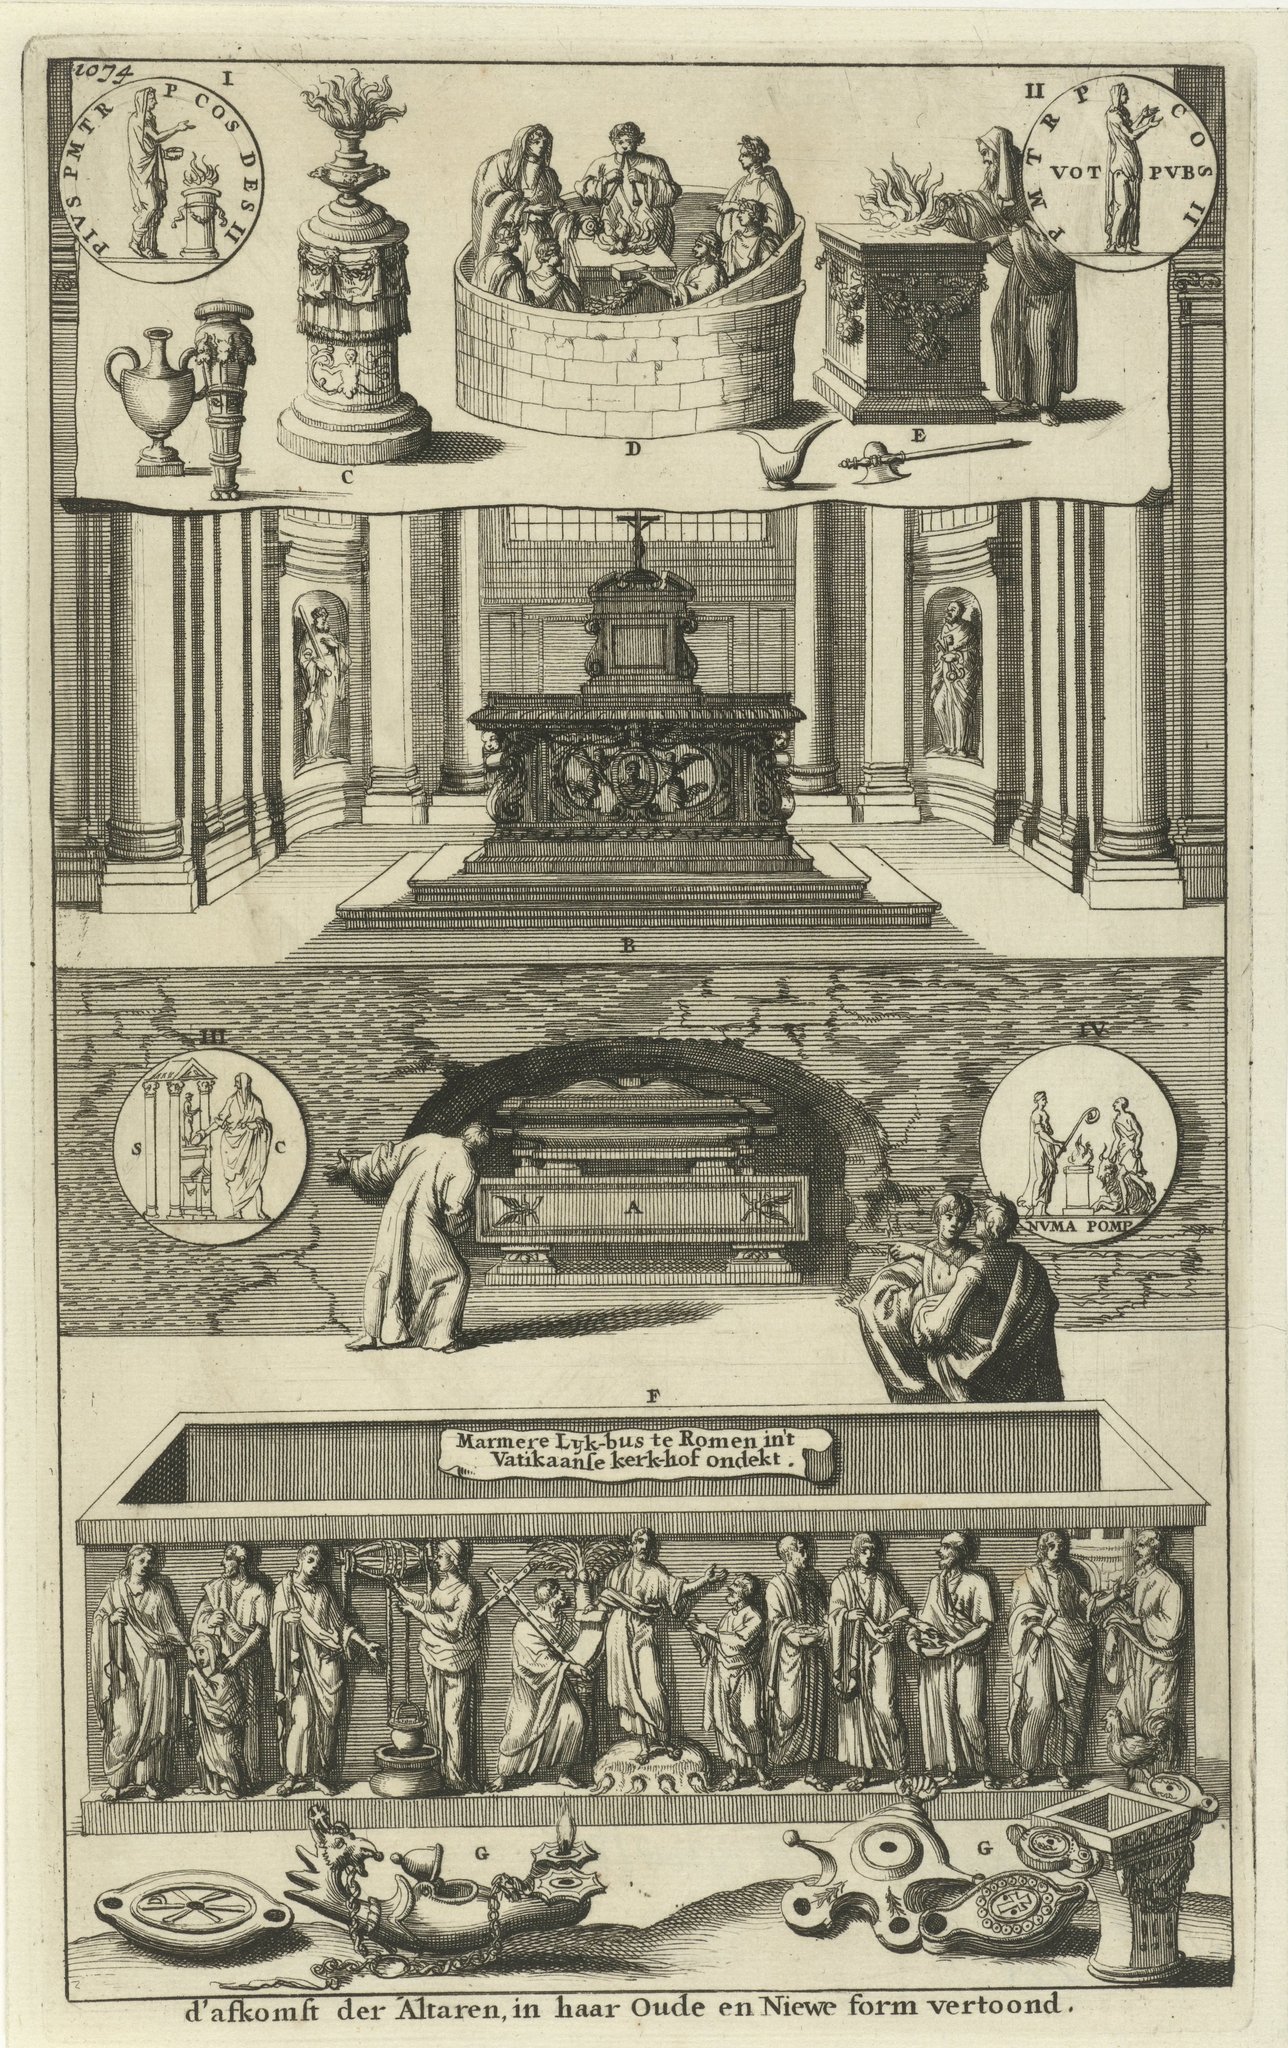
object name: book illustration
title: d'Afkomst der Altaren, in haar Oude en Niewe form vertoond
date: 1690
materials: paper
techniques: etching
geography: amsterdam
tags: altar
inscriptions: collector's mark: Lugt 2228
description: Illustratie opgenomen in: Goeree, Wilhelmus. Voor-bereidselen tot de bybelsche wysheid, en gebruik der heilige en kerklijke historien, 3 delen. Amsterdam: Wilhelmus Goeree I, 1690, dl. II.